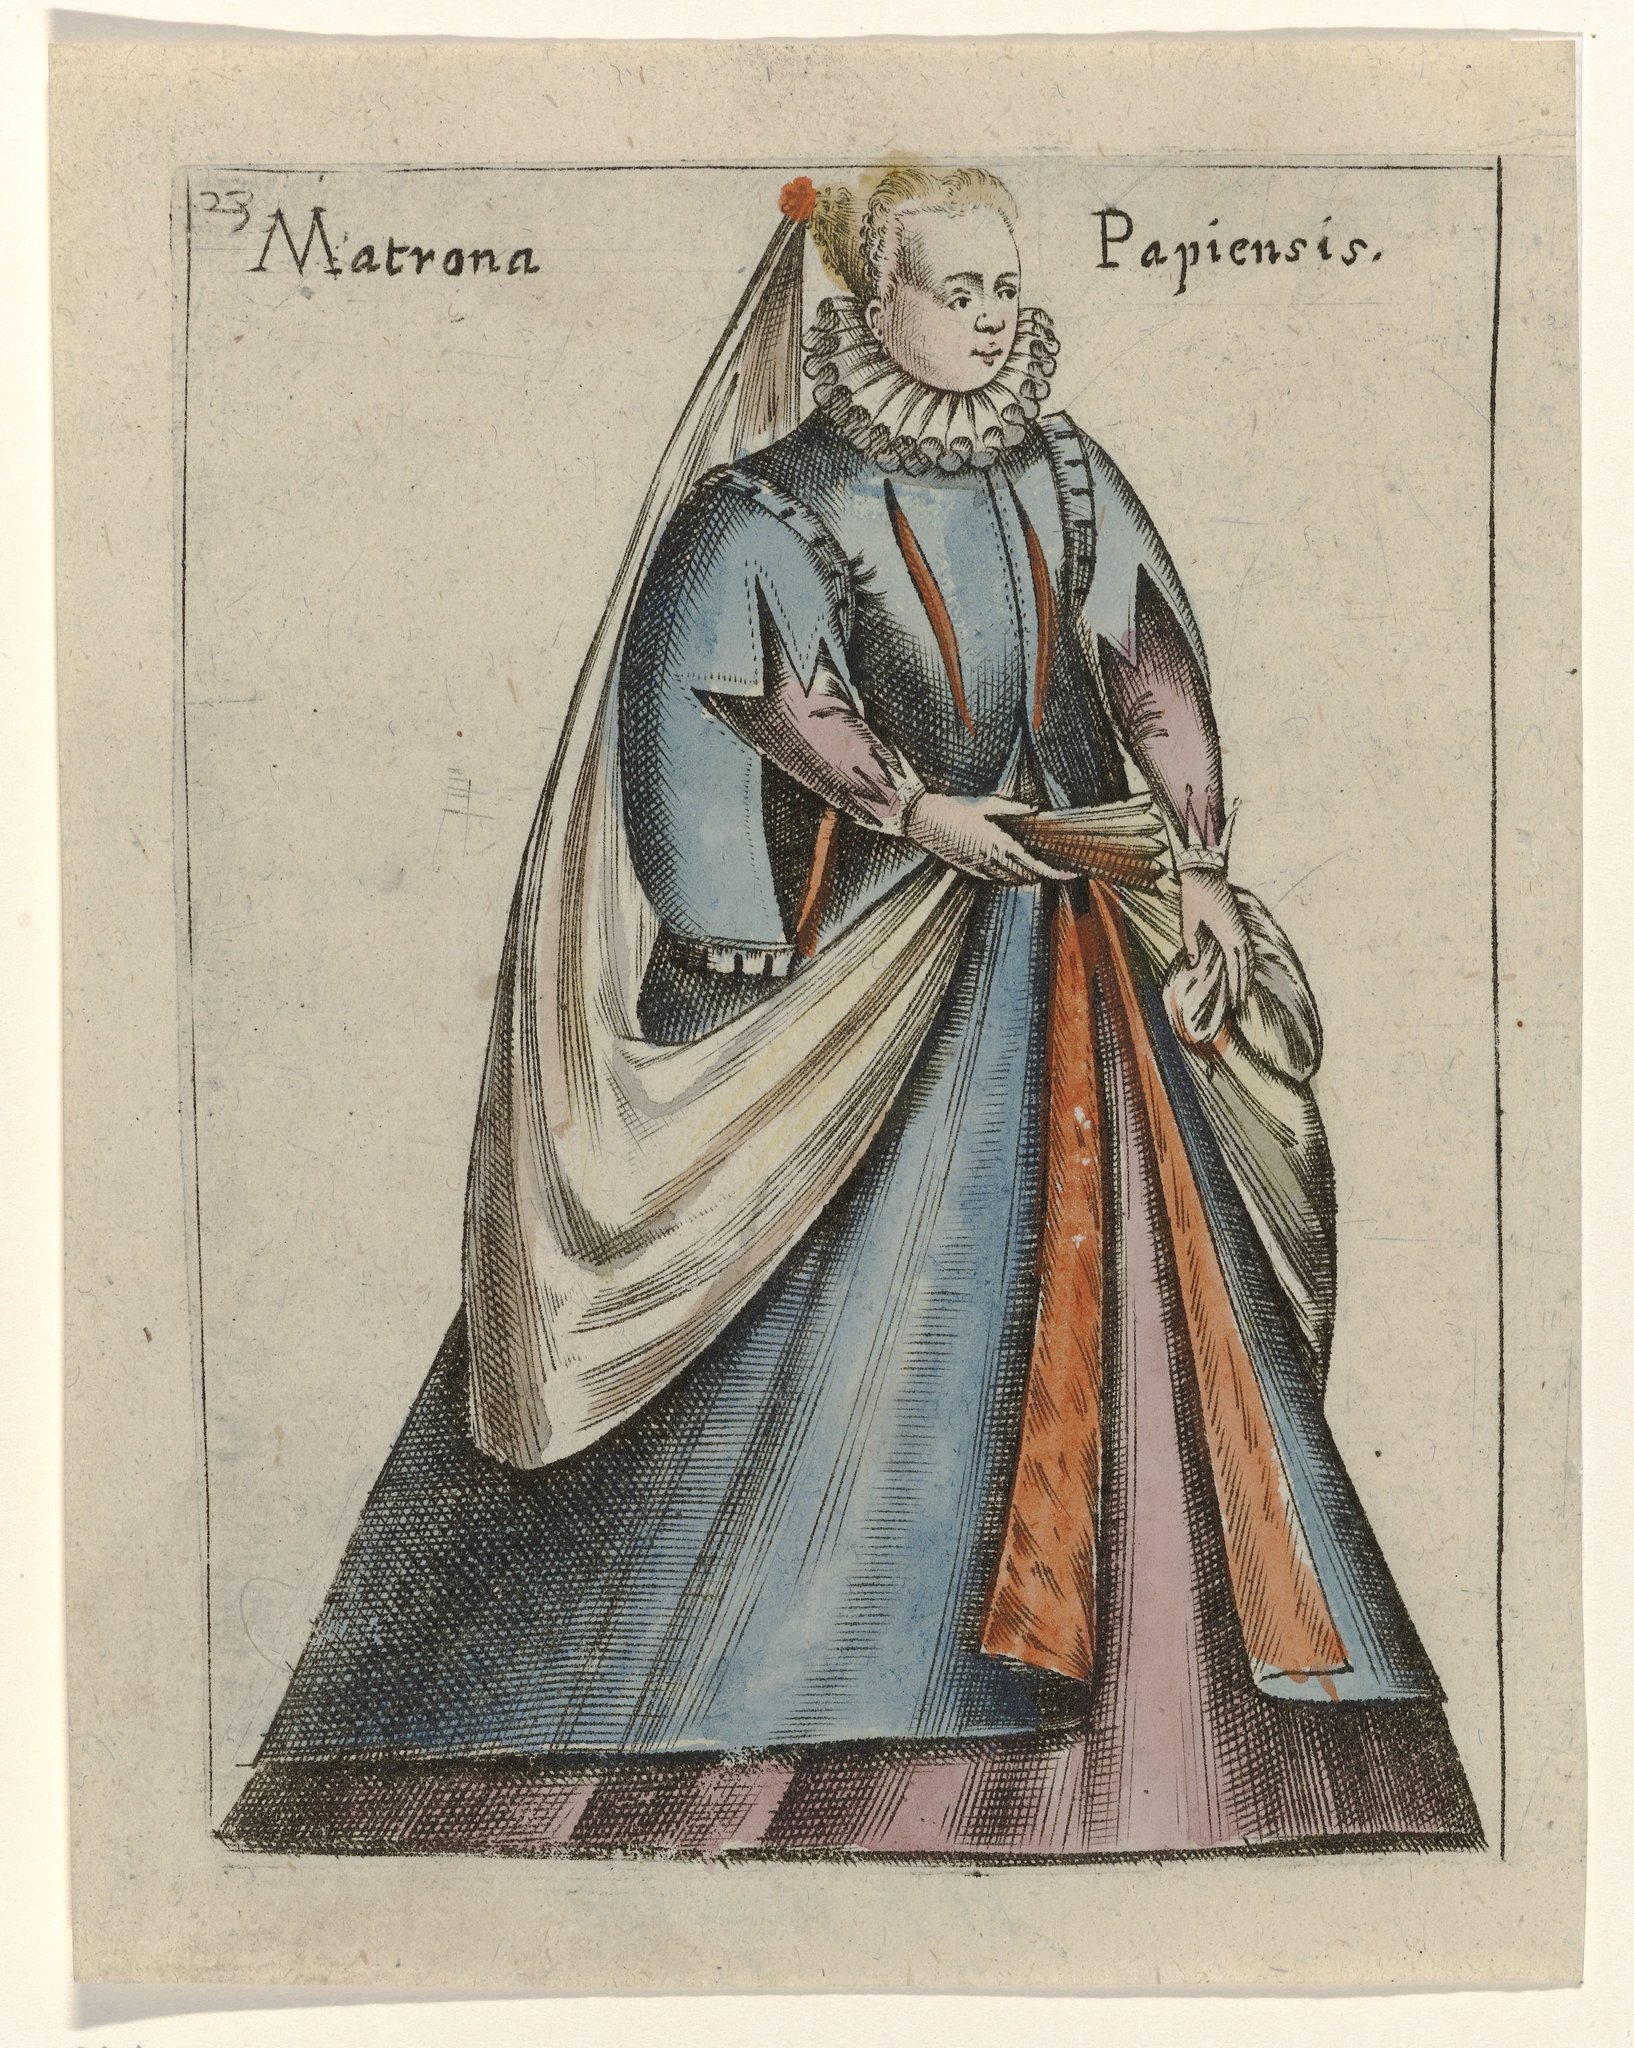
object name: print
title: Diversarum nationum habitus (...)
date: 1594-1596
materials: paper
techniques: engraving, hand coloring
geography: padua